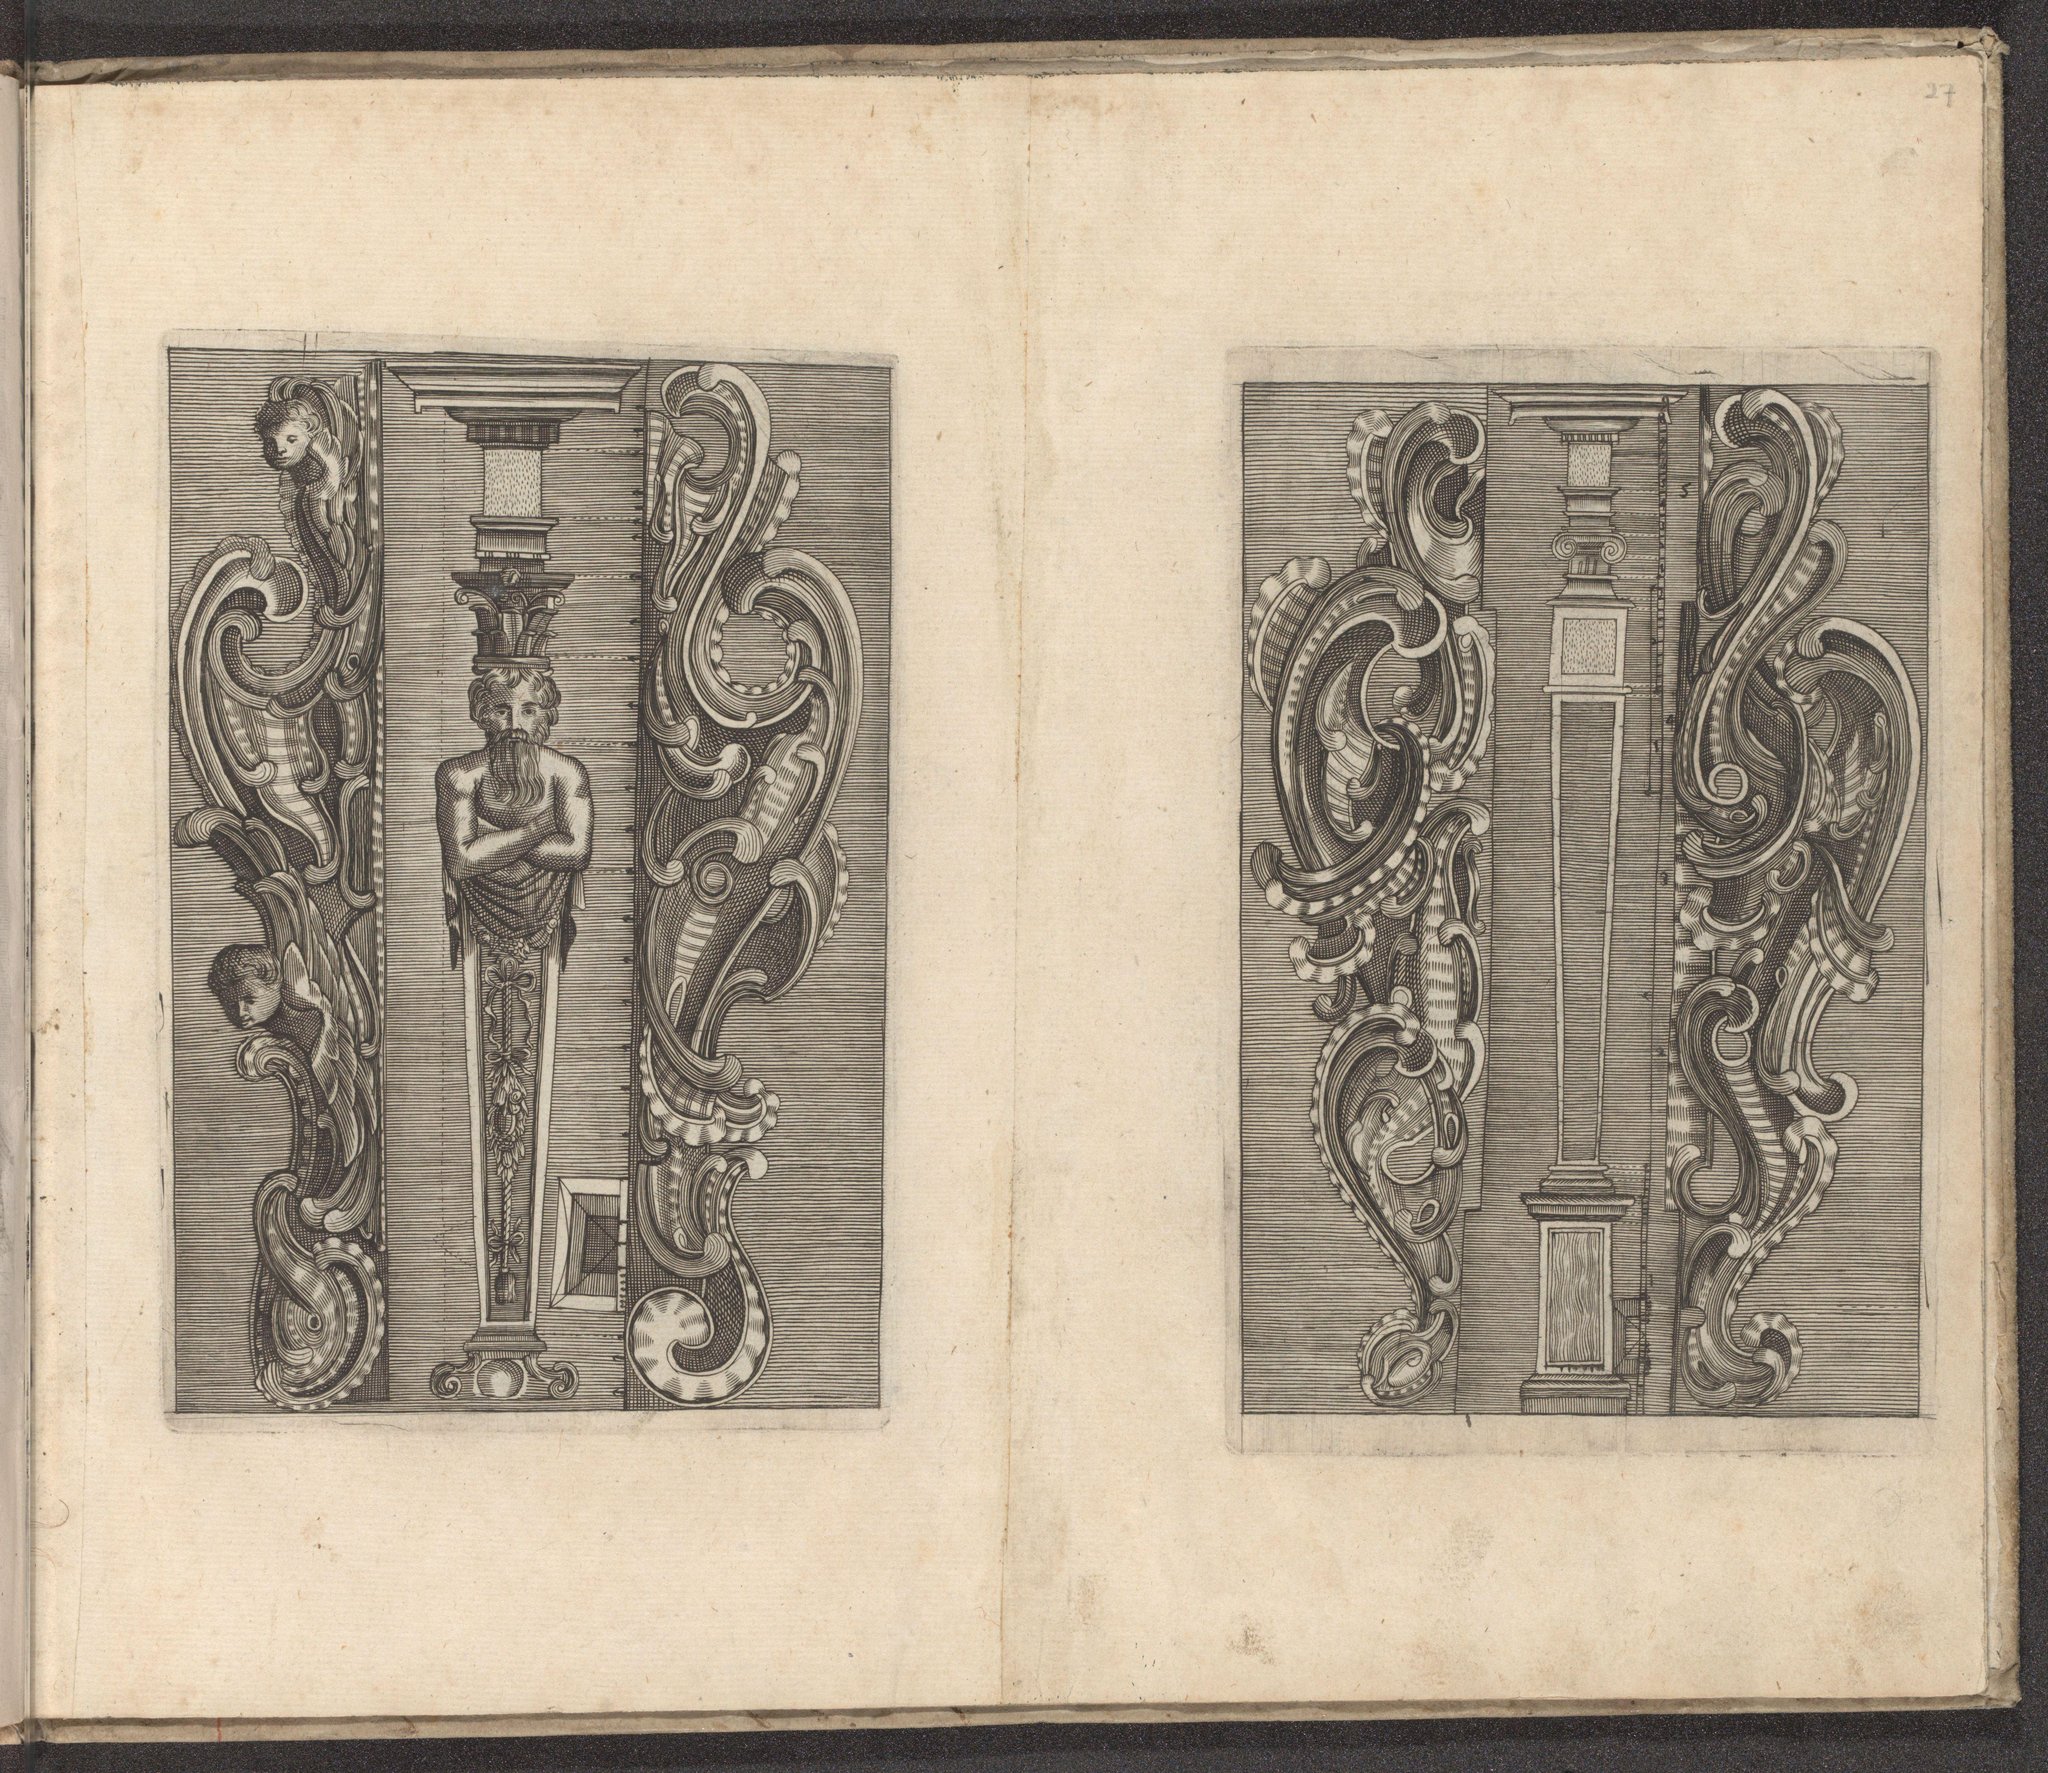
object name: ornament print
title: Verzierungen in Knorpelwerk für Schreiner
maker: Anonymous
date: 1600-1699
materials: paper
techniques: engraving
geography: germany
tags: auricular ornament, lobe style ~ ornament, column, pillar ~ architecture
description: Twee voorstellingen op een tweedelig albumblad. Links een herm met een Korinthisch hoofdgestel geflankeerd door ornamenten in kwabstijl. Rechts een op een voetstuk en met een Ionisch hoofdgestel, eveneens geflankeerd door ornamenten in kwabstijl. De prent maakt deel uit van een album.